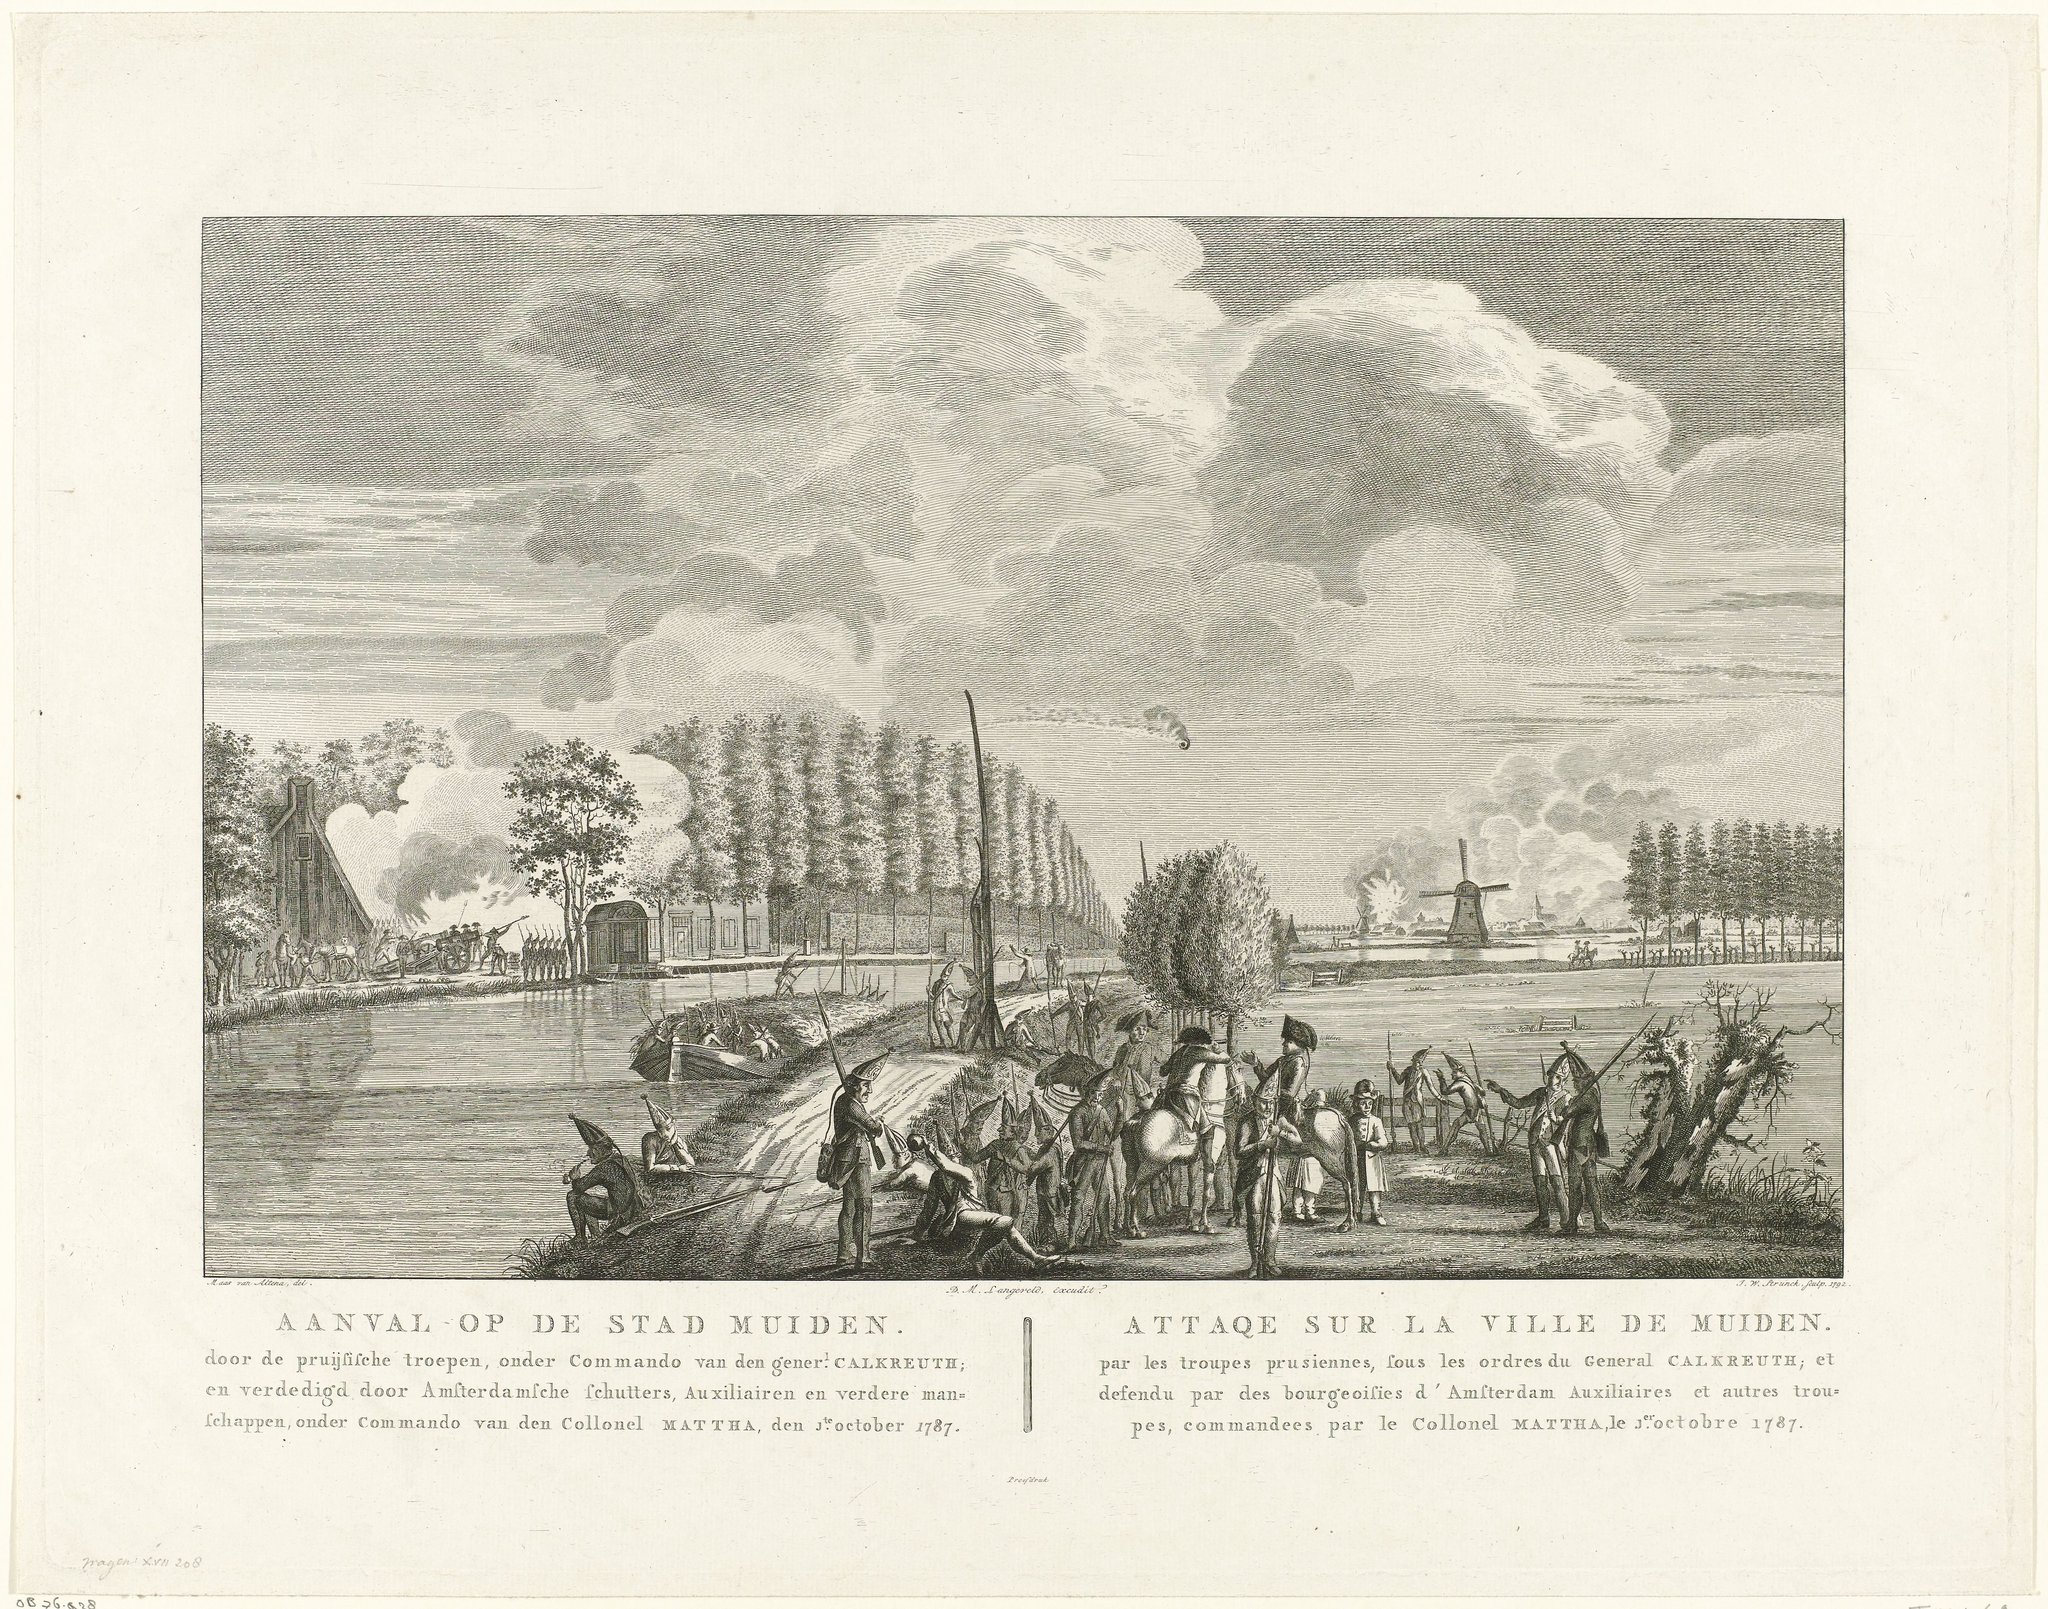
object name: history print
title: Gevechten met de Pruisische troepen rond Amsterdam in 1787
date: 1792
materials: paper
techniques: engraving, etching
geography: northern netherlands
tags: berlin, bombardment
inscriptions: date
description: Aanval op de stad Muiden door de Pruisische troepen onder generaal Friedrich Adolf von Kalckreuth, verdedigd door Amsterdamse schutters onder kolonel Mattha, 1 oktober 1787. Op de voorgrond de Pruisen, op de achtergrond het bombardement van de stad. Onderdeel van een groep van zeven prenten van de gevechten met de Pruissische troepen rond Amsterdam in 1787.